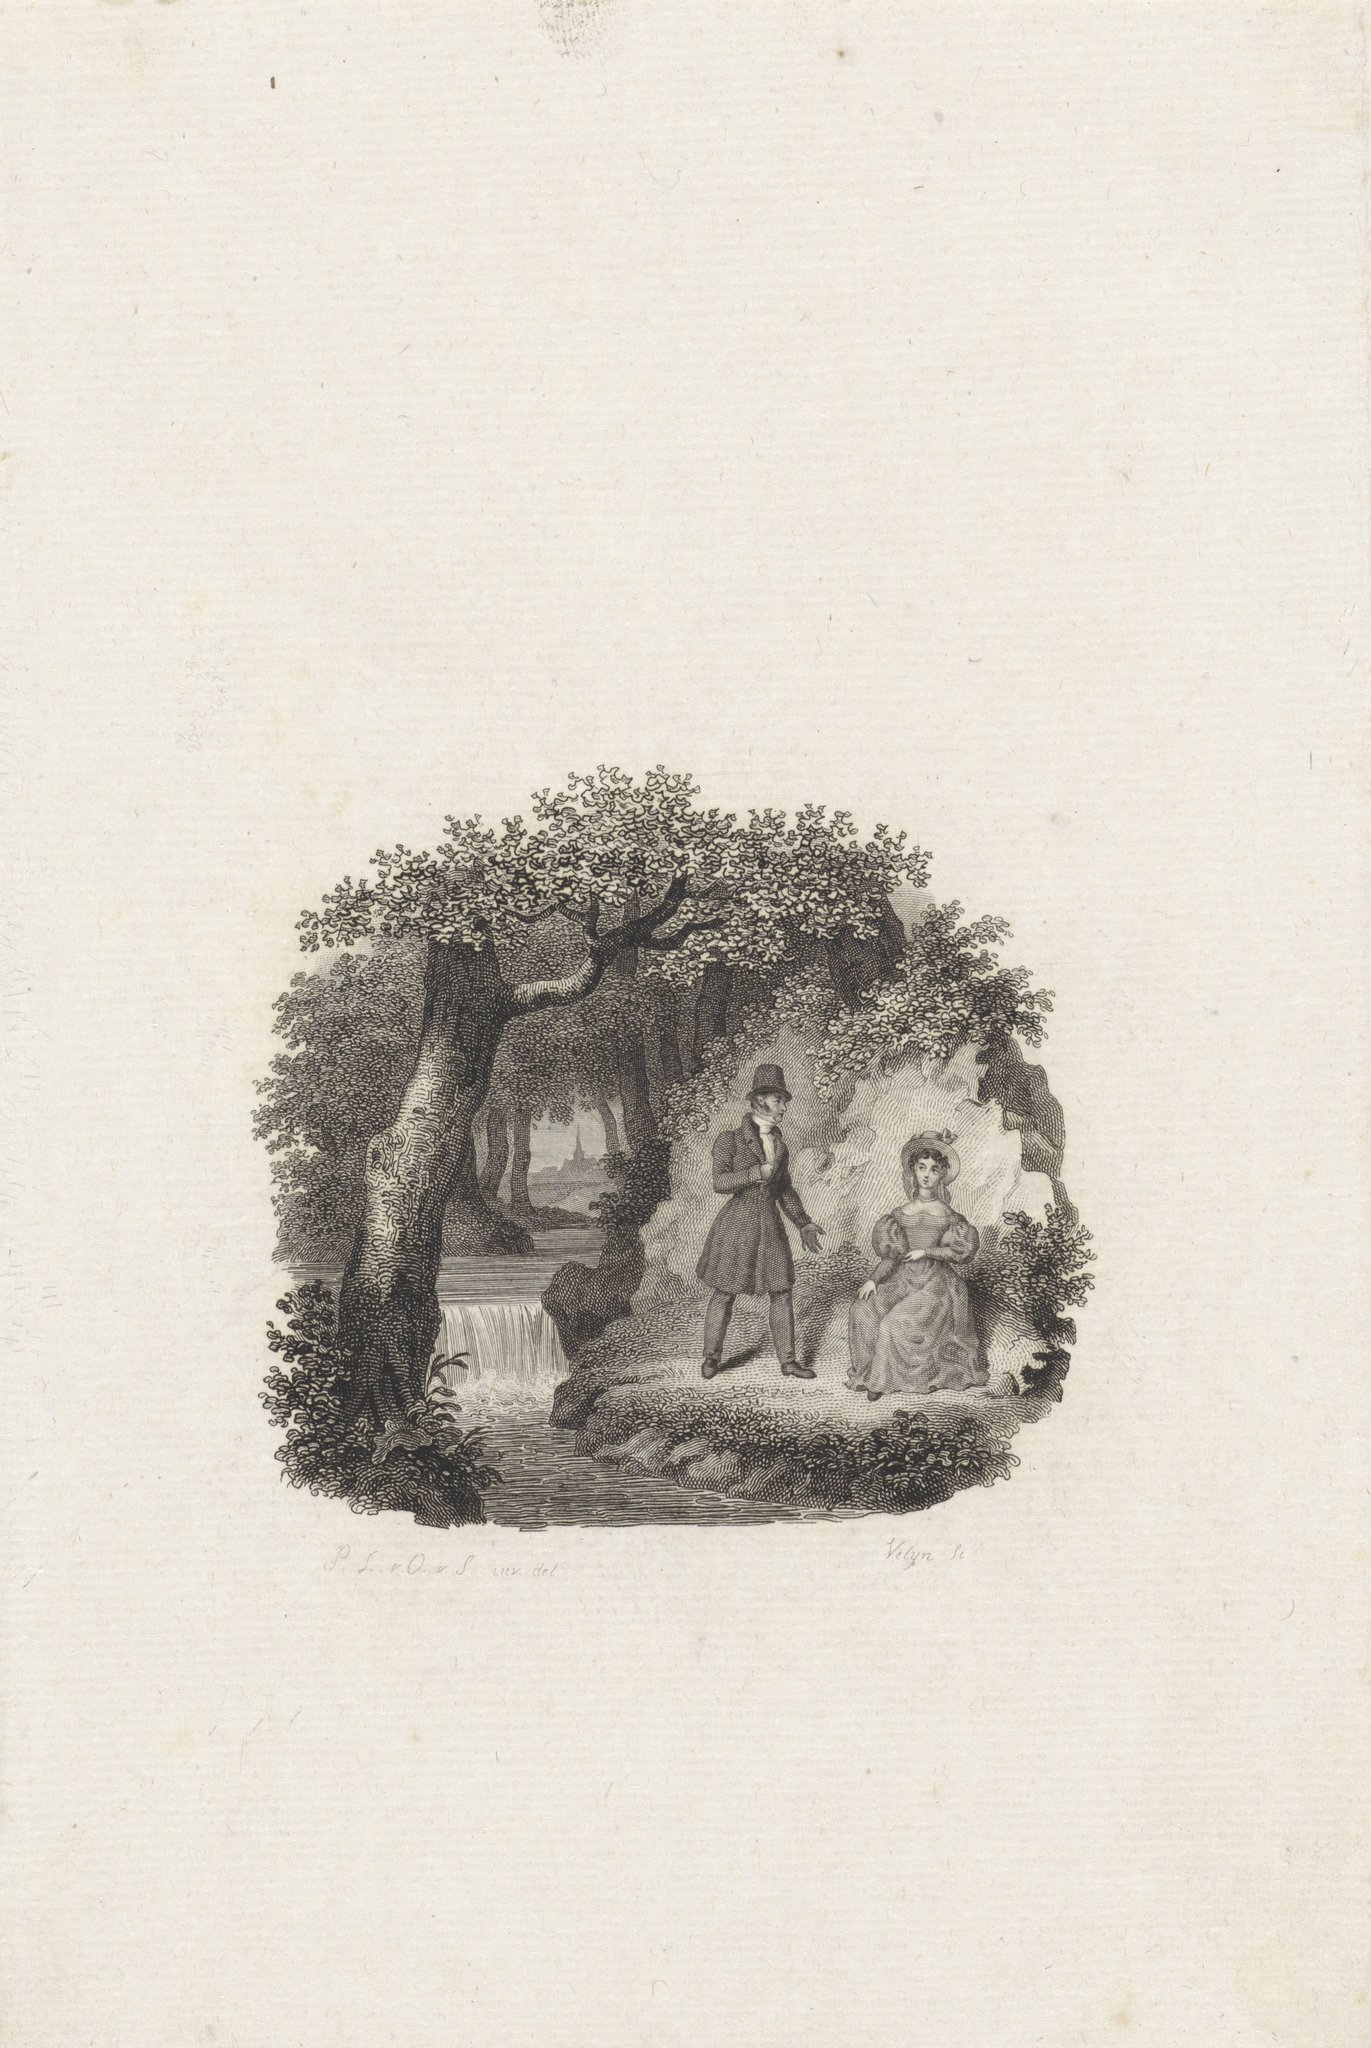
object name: print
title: Paar in een bos bij een waterval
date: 1797-1836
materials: paper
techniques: etching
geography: netherlands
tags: forest, wood, waterfall (+ landscape with figures, staffage), couple of lovers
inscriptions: collector's mark: Lugt 2228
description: Een paar in een bos bij een waterval, aan de rand van een beek.